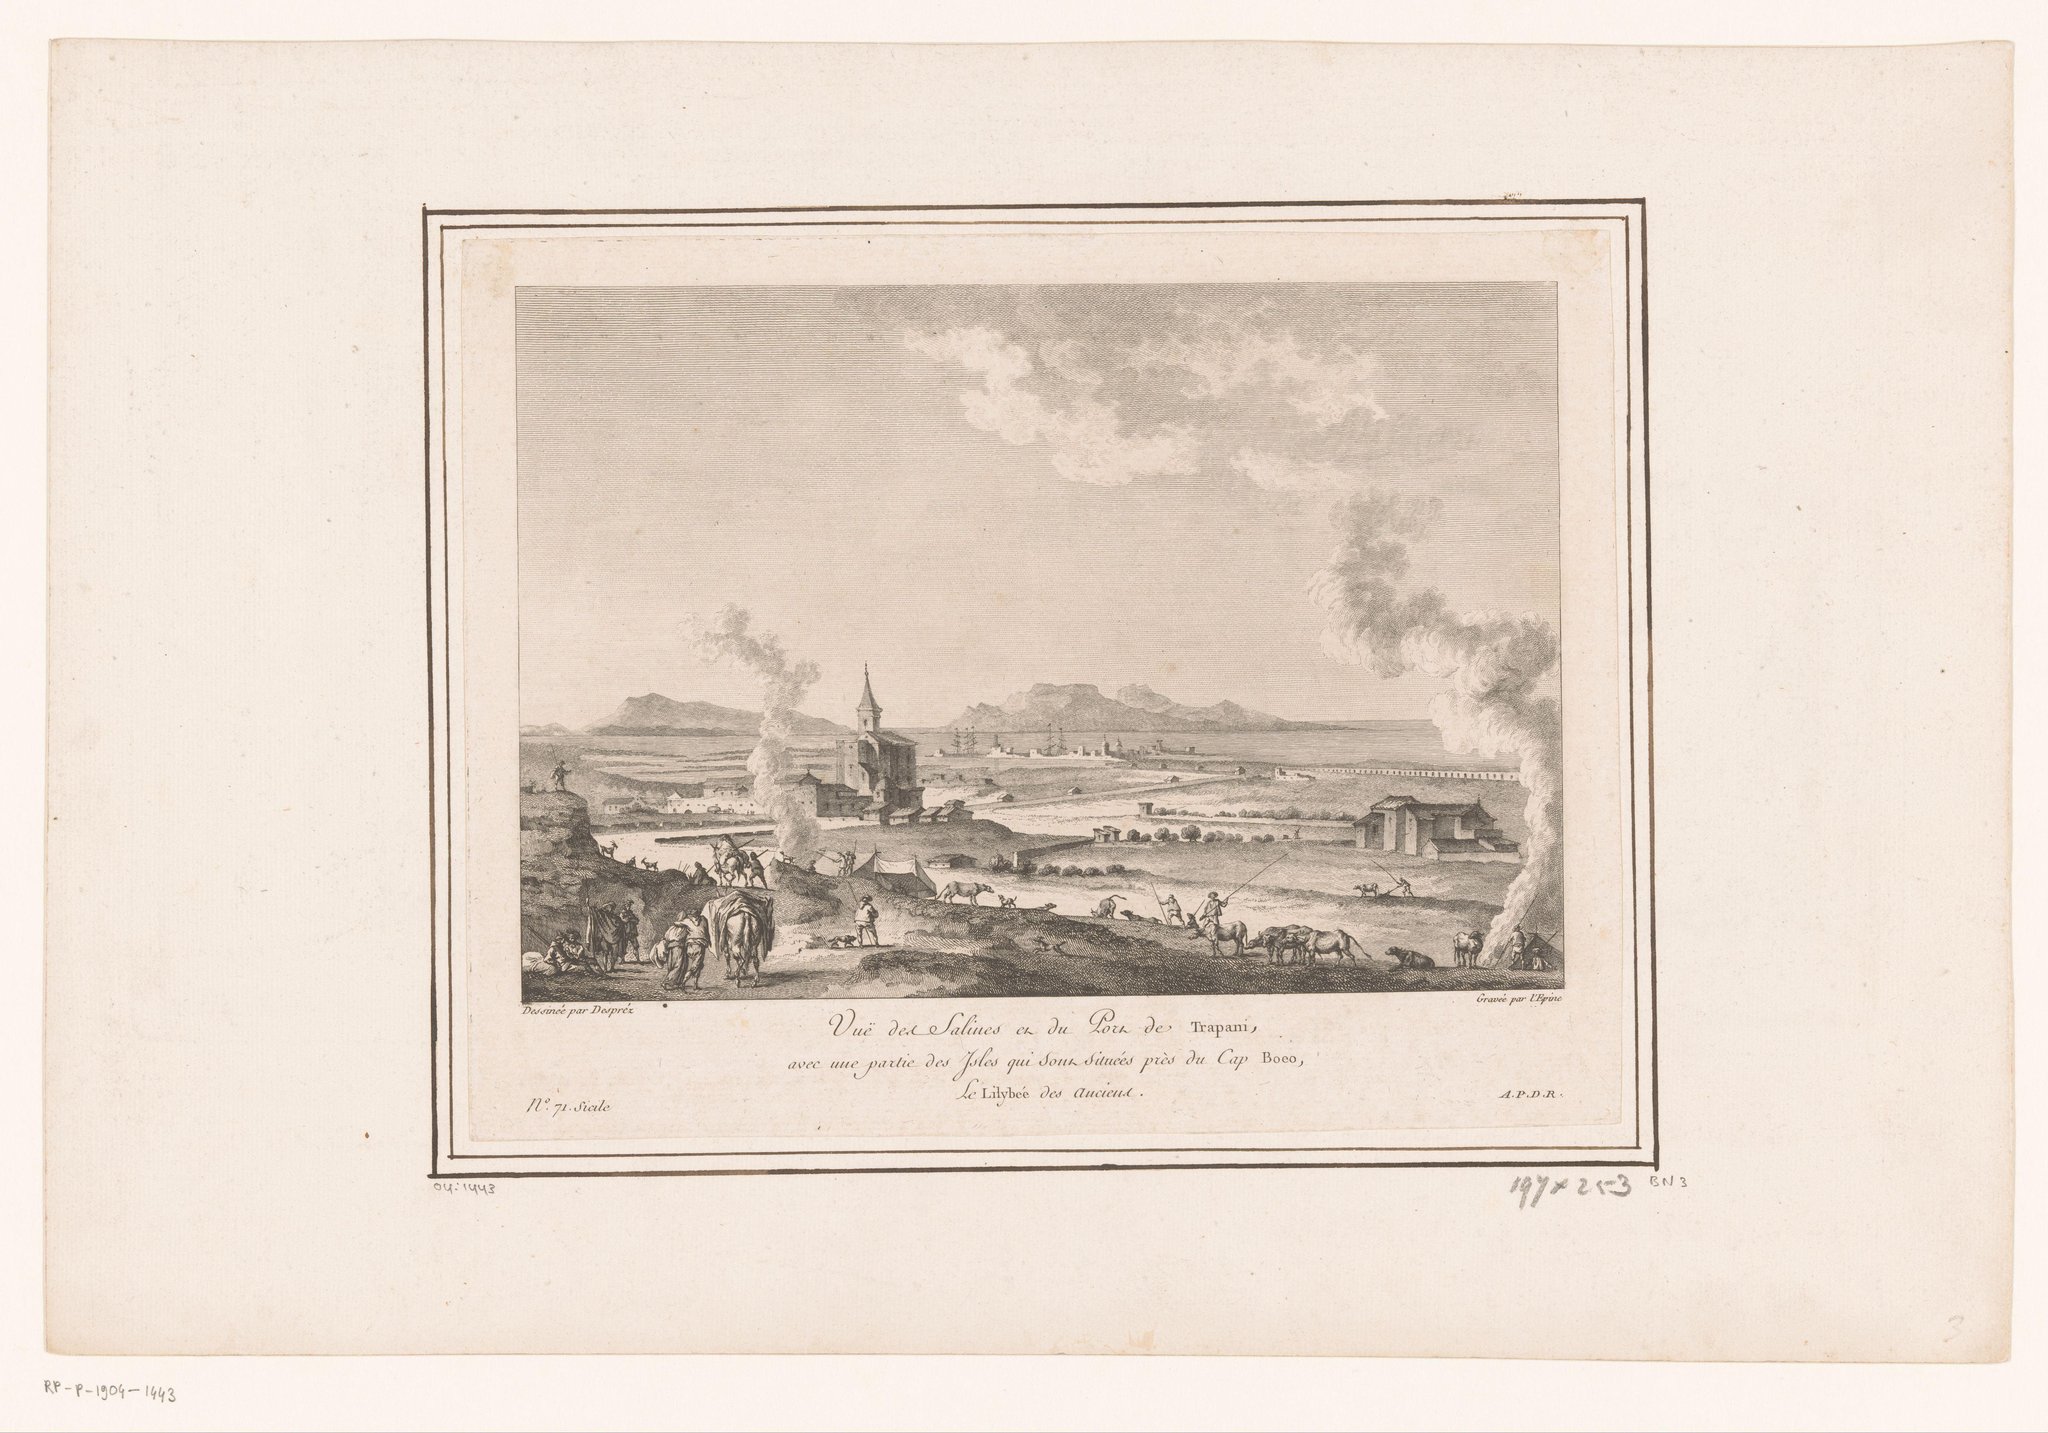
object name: print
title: Vuë des Salines et du Port de Trapani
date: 1785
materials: ink, paper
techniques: etching, pen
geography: france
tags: harbour, salt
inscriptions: collector's mark: Lugt 2228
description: Betreft mogelijk een illustratie uit: Abbé de Saint-Non, Jean-Claude Richard. Voyage Pittoresque ou Description des Royaumes de Naples et de Sicile. Parijs: Clousier imprimeur, 1781-1786. De prent bevindt zich op een opzetvel met op het verso een gegraveerde plattegrond van een 'Jagdhause', uitgegeven door I. Wolff.